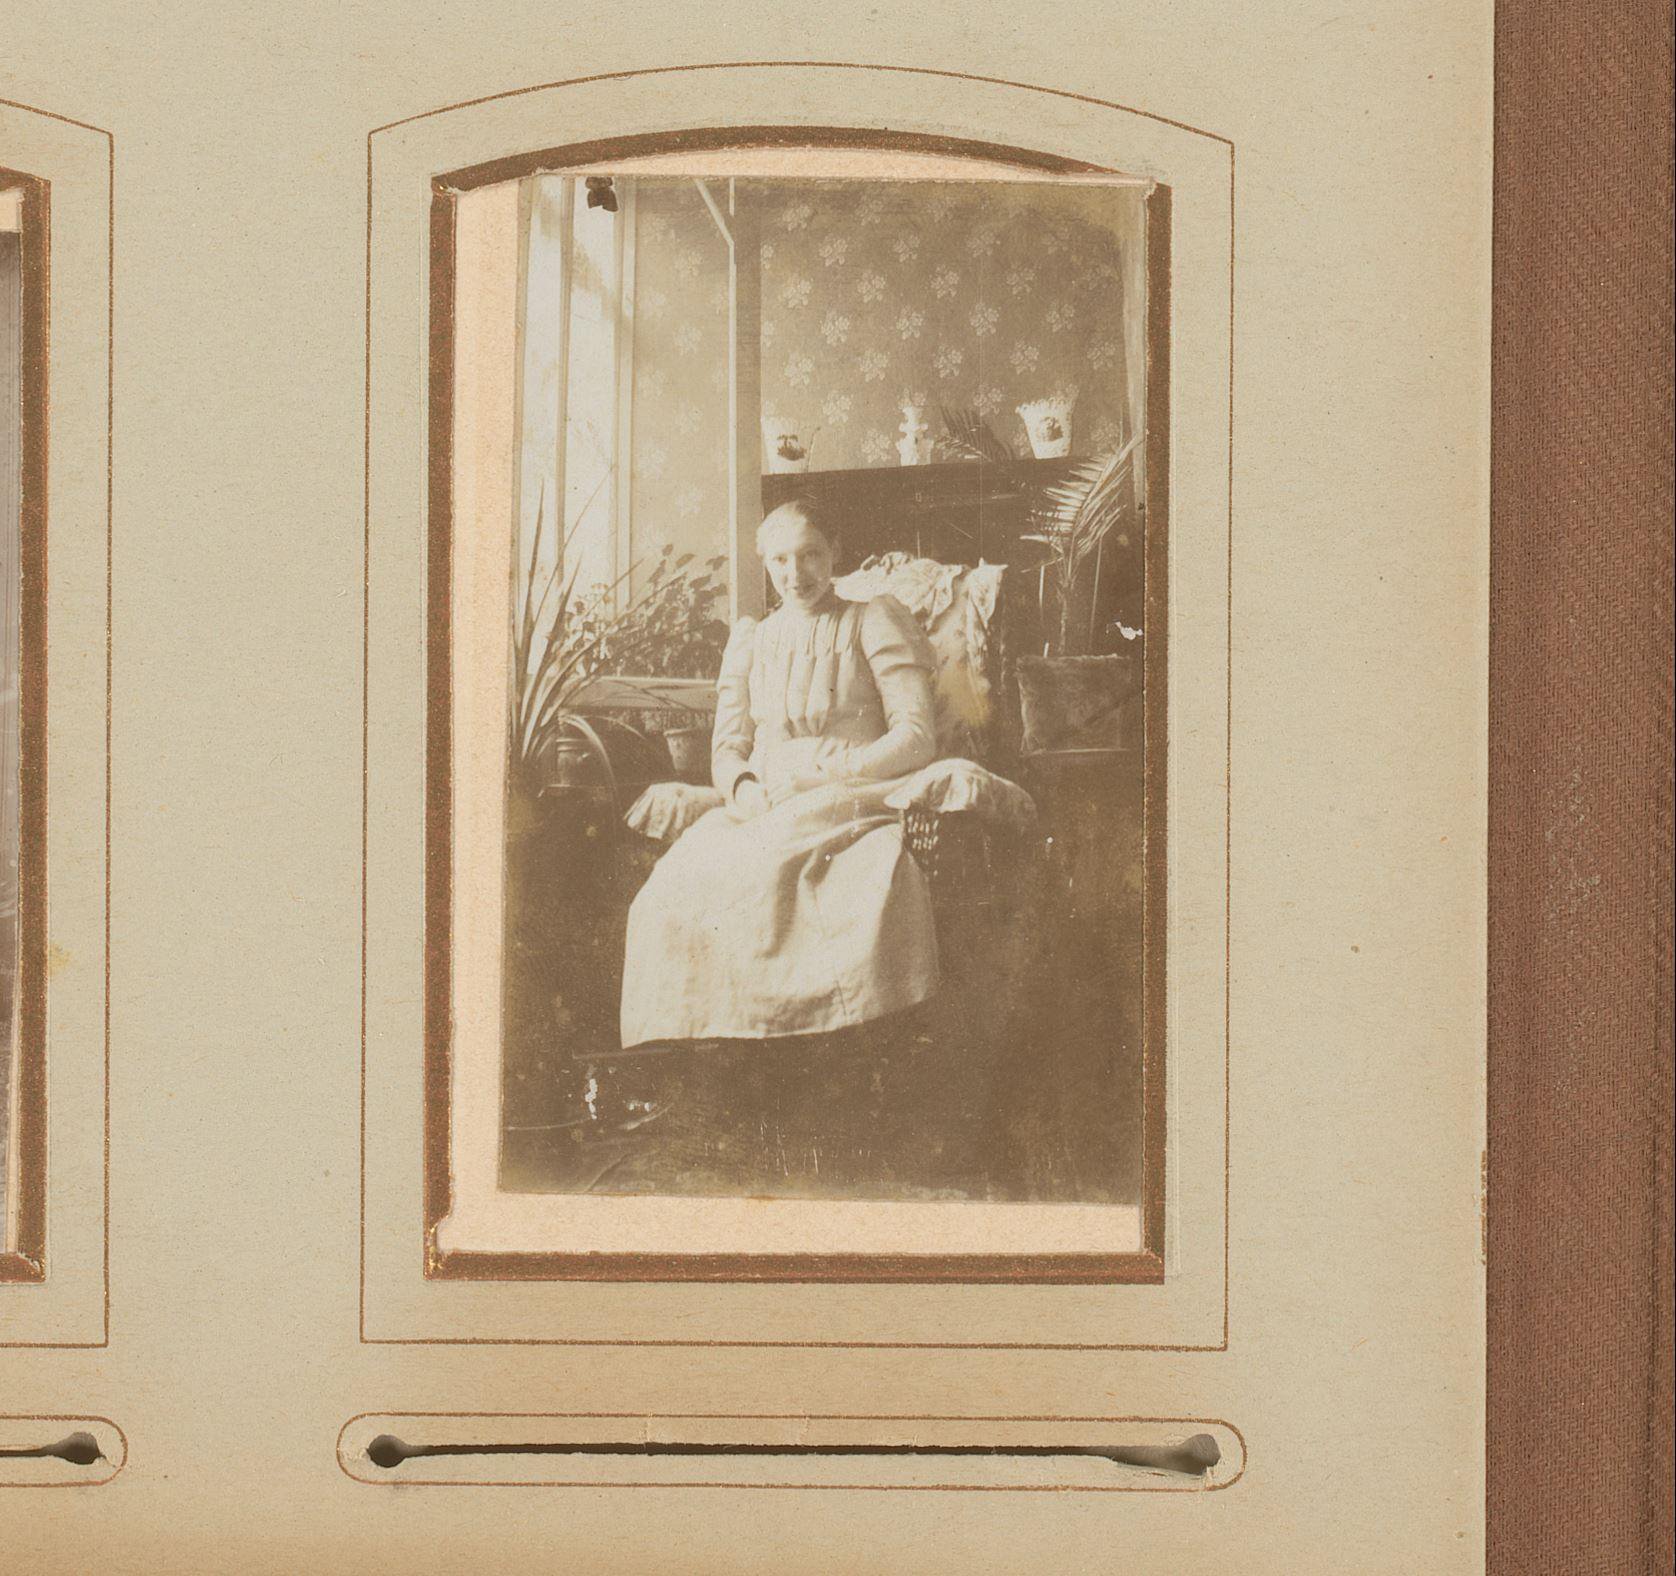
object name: carte de visite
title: Portret van een meisje, zittend in een interieur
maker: Anonymous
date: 1880-1920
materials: cardboard, photographic support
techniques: collodion silver print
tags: sitting figure - aa - female human figure, historical persons - bb - woman, girl (child between toddler and youth), interior of the house